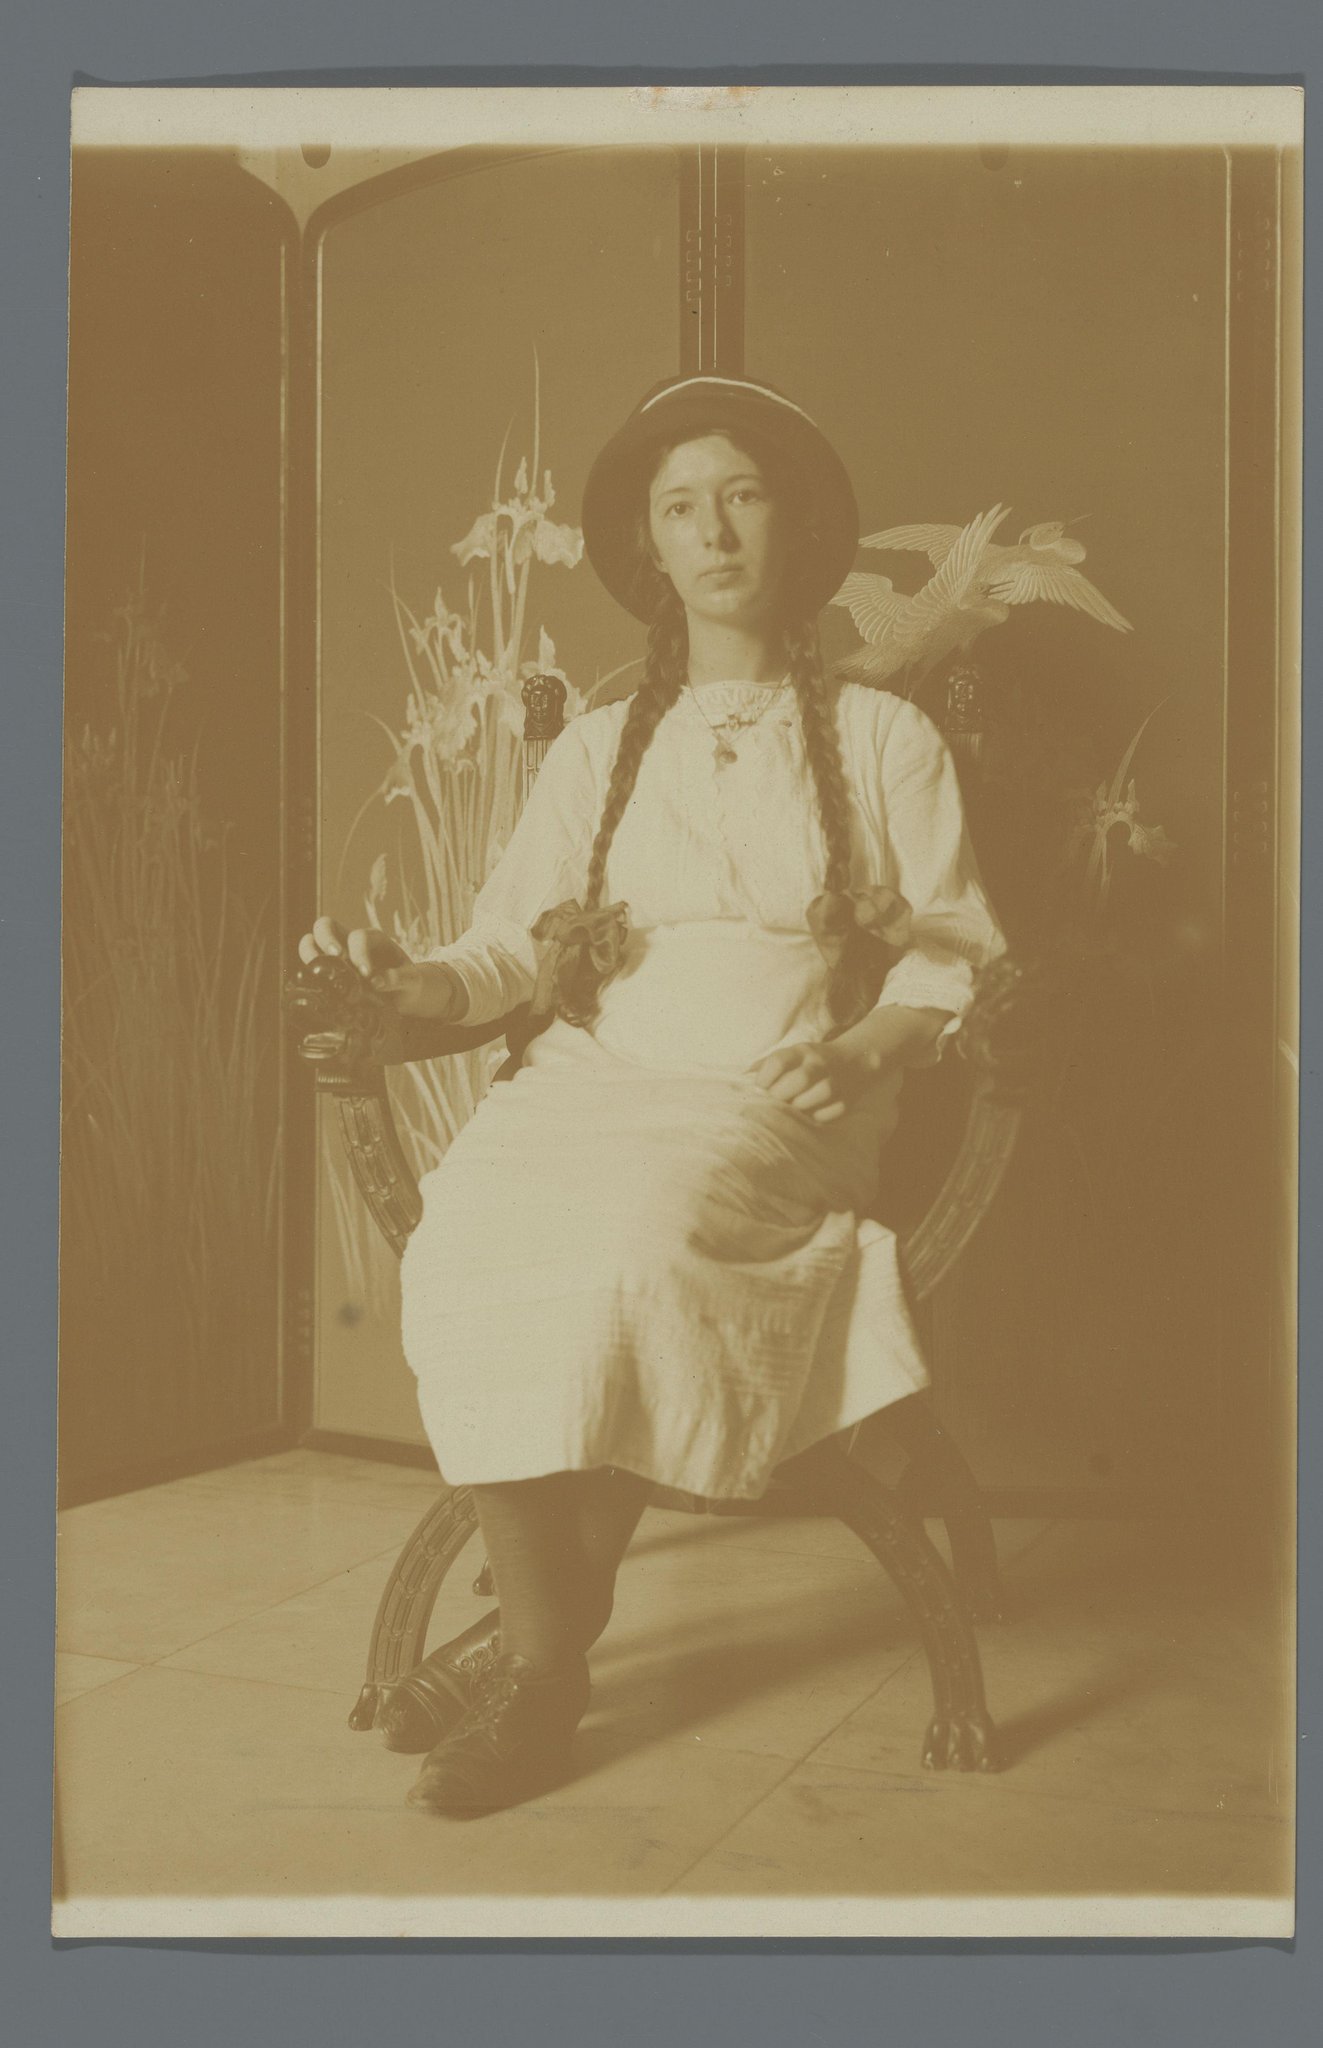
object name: photograph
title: Portret van J. H. Marmelstein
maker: Anonymous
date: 1914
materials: photographic support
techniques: gelatin silver print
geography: batavia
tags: johanna hermina marmelstein, historical persons - bb - woman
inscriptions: annotation: ‘Batavia./ bijna 17 jaar.’, date: ‘17 Oct. 1914.’